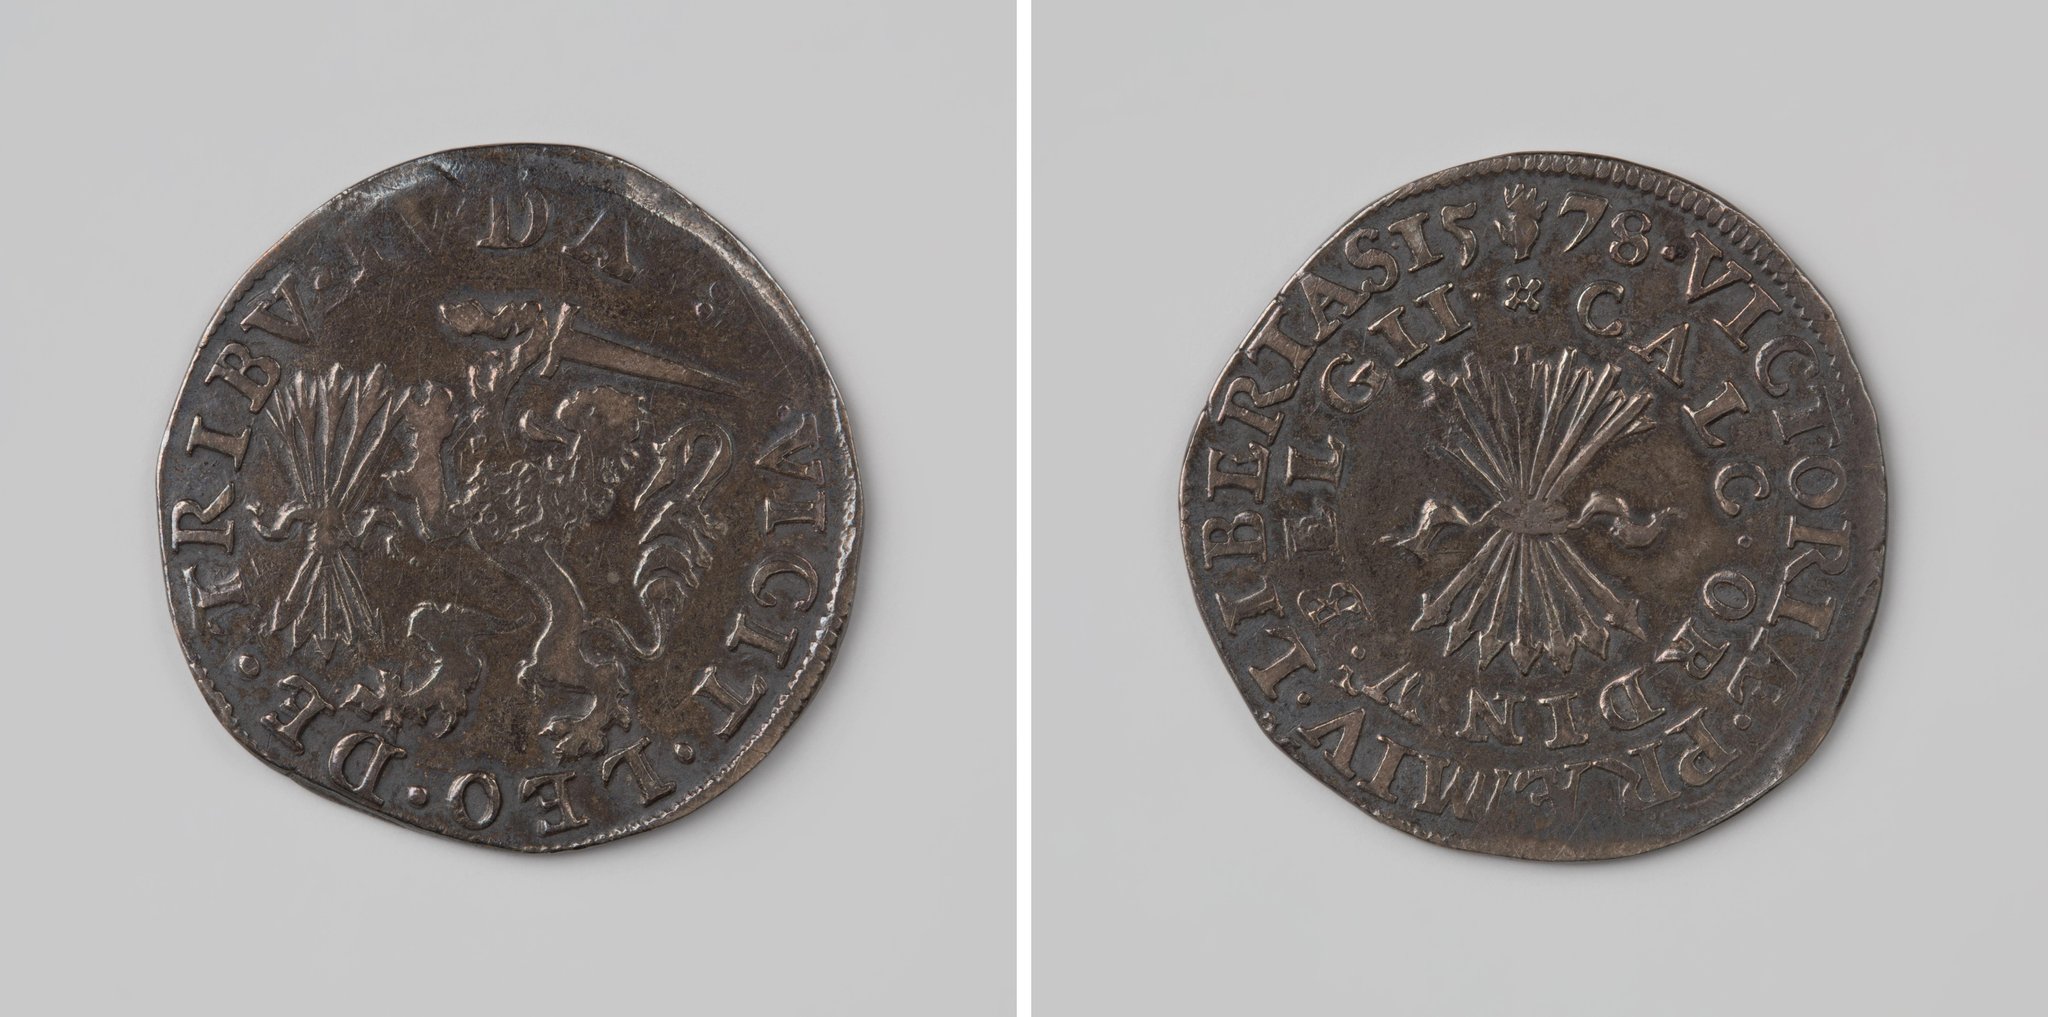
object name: jeton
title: Overwinning van de opstandelingen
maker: Anonymous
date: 1578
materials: silver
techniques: striking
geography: antwerp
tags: staten-generaal, tachtigjarige oorlog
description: Zilveren penning. Voorzijde: leeuw met zwaard en bundel van vijf pijlen in klauwen binnen omschrift. Keerzijde: bundel van zeven pijlen binnen tweeregelig omschrift